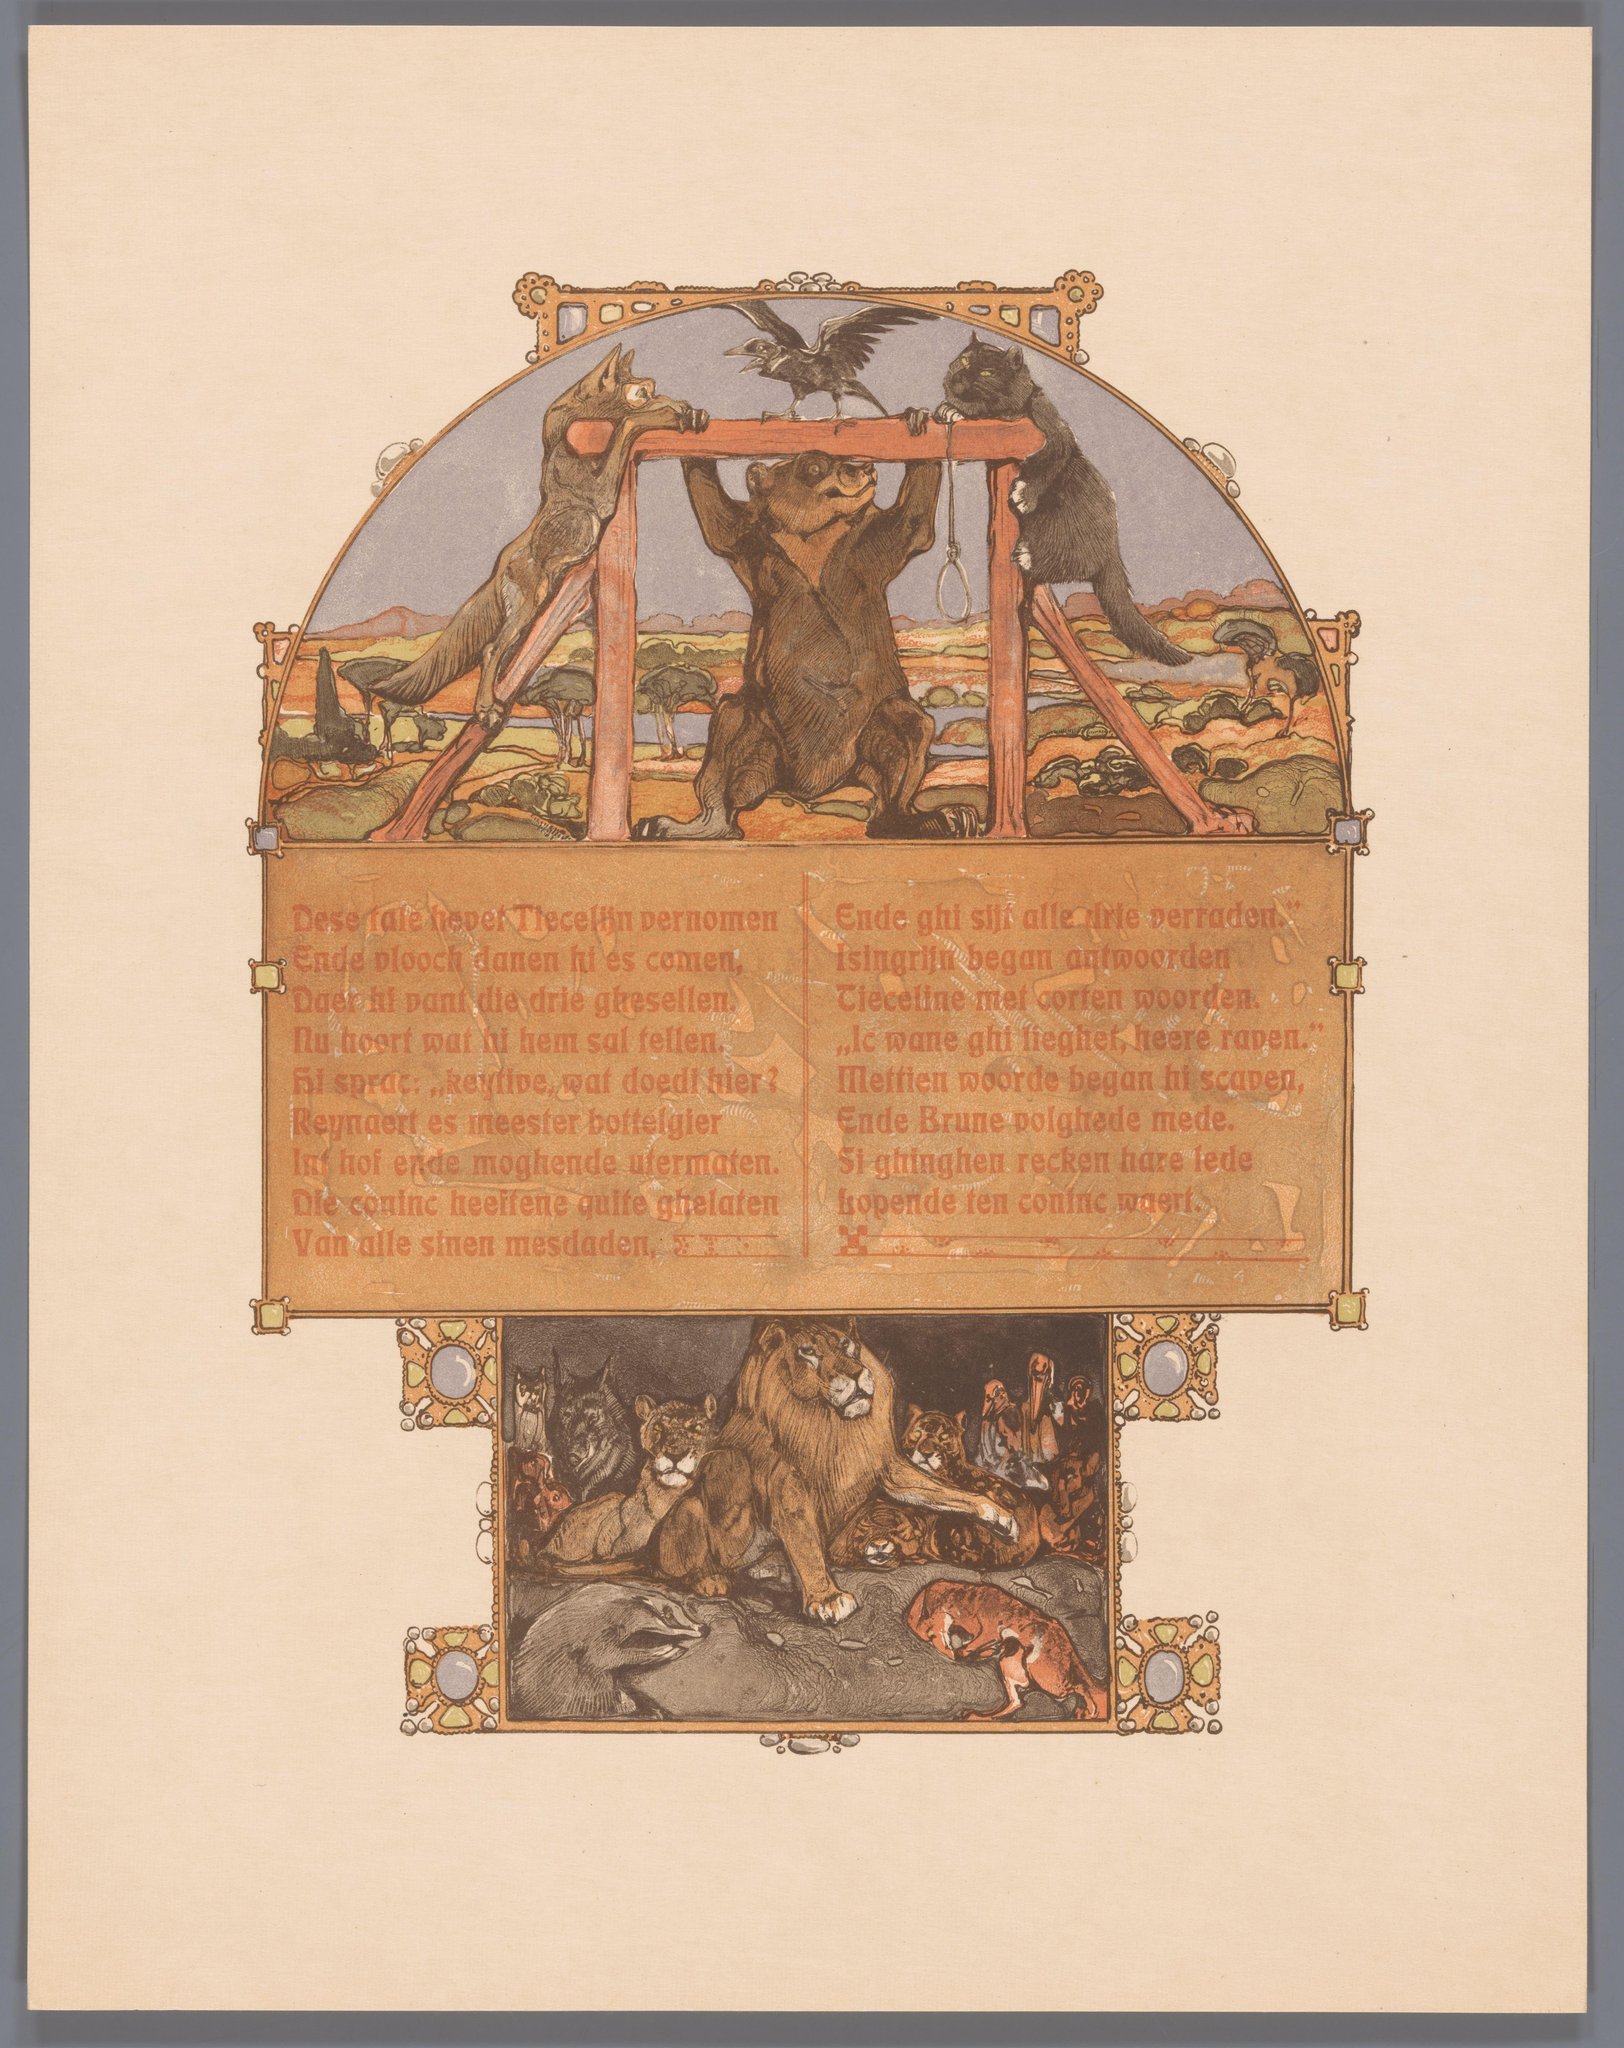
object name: book illustration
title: Vos (Reinaert), beer (Bruun), kat (Tybeert) en raaf (Tiecelijn) bij galg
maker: bernard willem wierink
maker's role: draughtsman, print maker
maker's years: 1856-1939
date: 1910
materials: paper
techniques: lithograph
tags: fable of reynard the fox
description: Prent gebruikt in: Streuvels, Stijn (Frank Lateur). Reinaert de Vos naar verschillende uitgaven van het middeleeuwsche epos. Amsterdam: L.J. Veen, 1910.